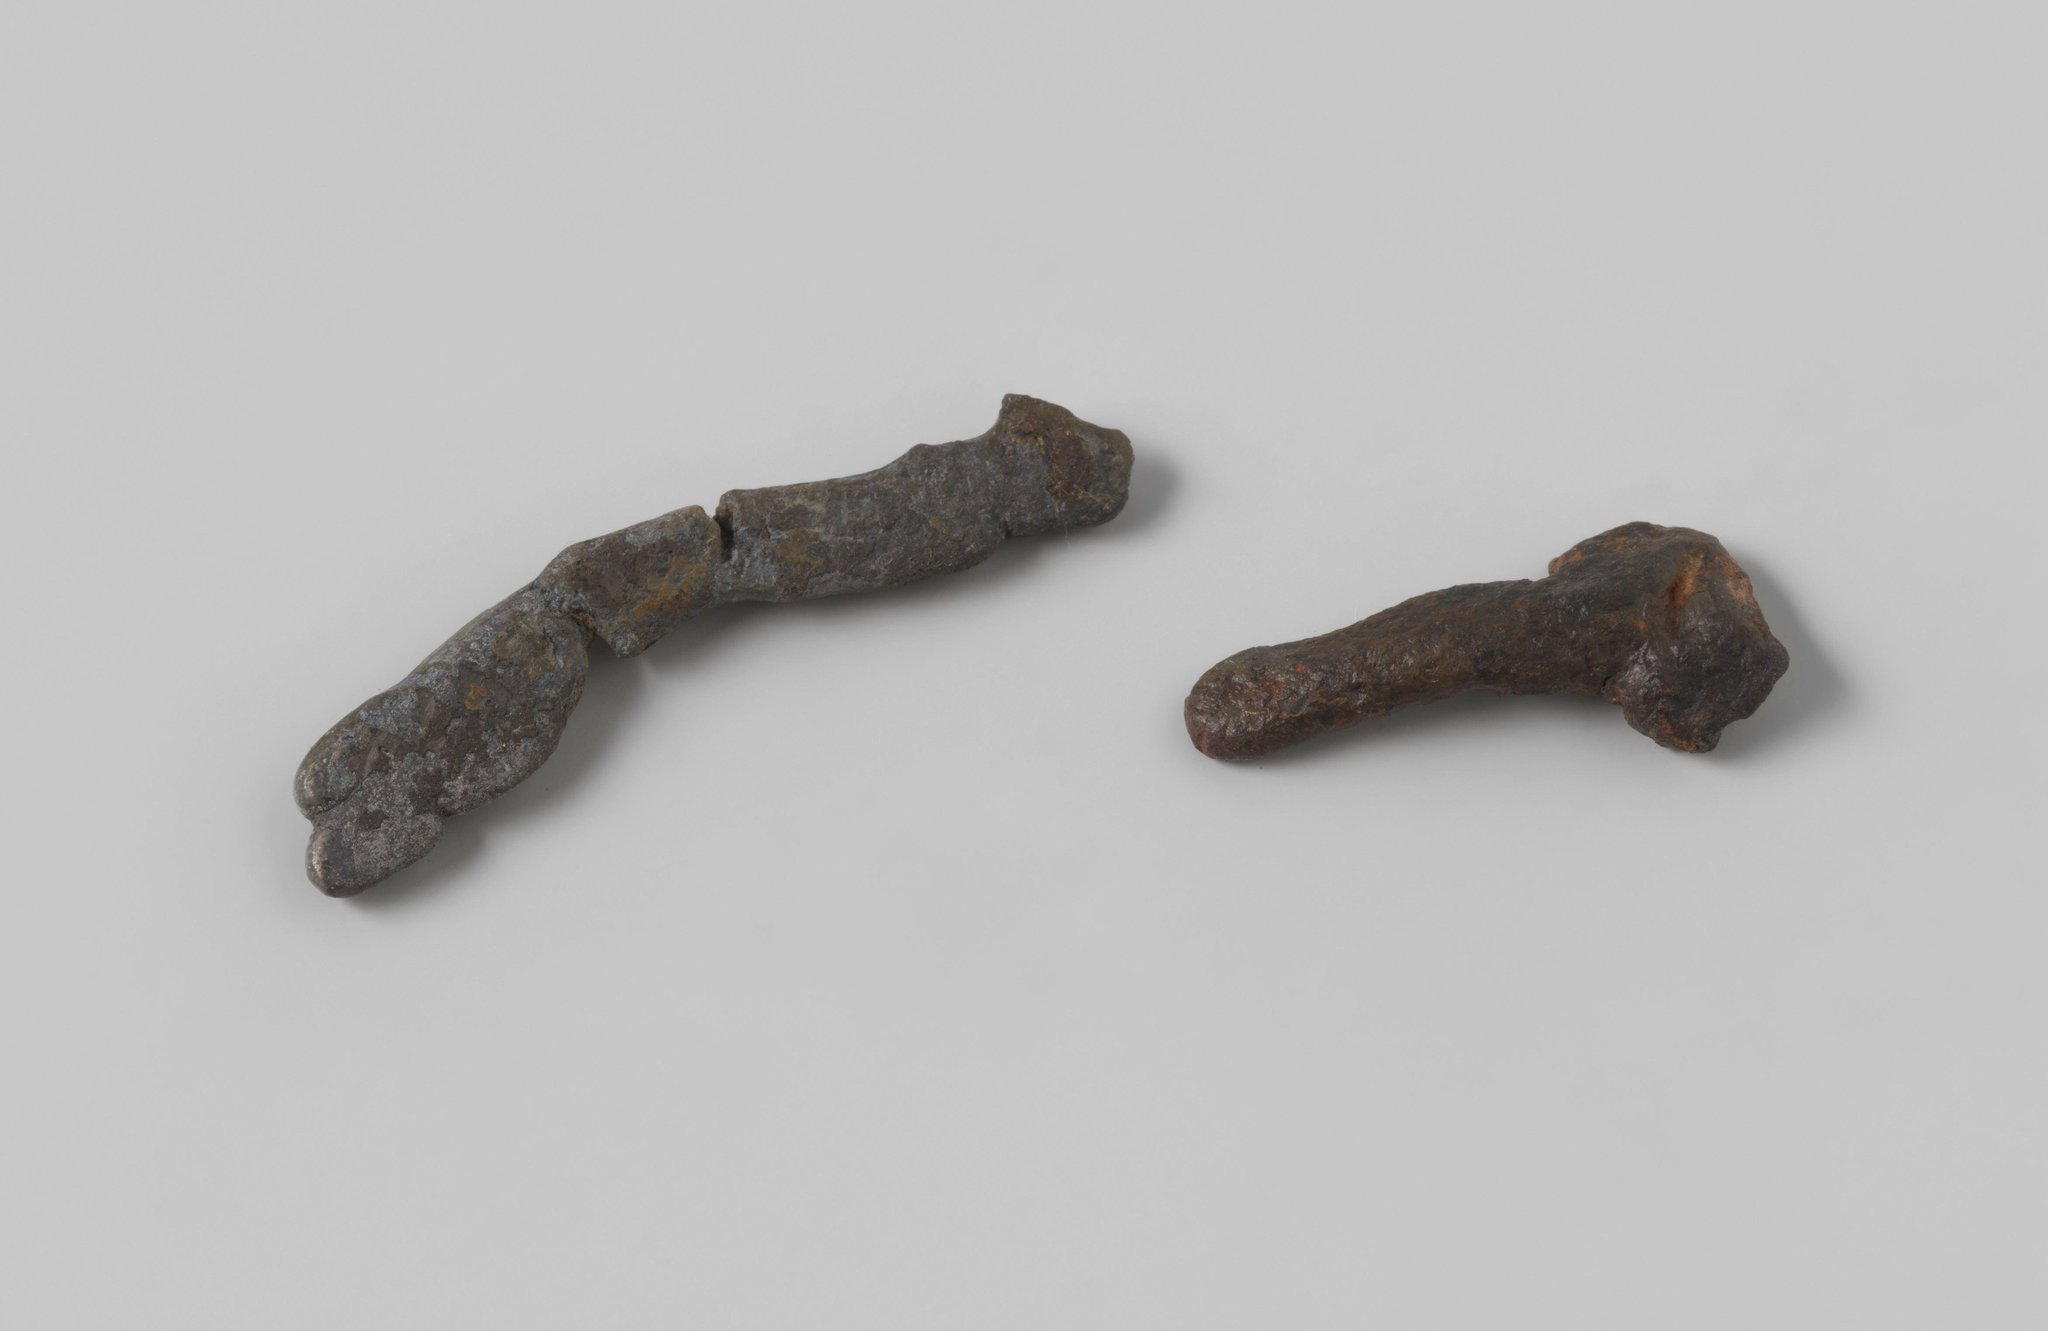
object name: cartridge shell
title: Fragmenten beslag van patroonhulzen uit het wrak van de Oost-Indiëvaarder Hollandia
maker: Anonymous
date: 1700-1743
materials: lead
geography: netherlands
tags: verenigde oostindische compagnie, hollandia (schip), annet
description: Cartridge case, tube solder; id. NG 1979-205H549.